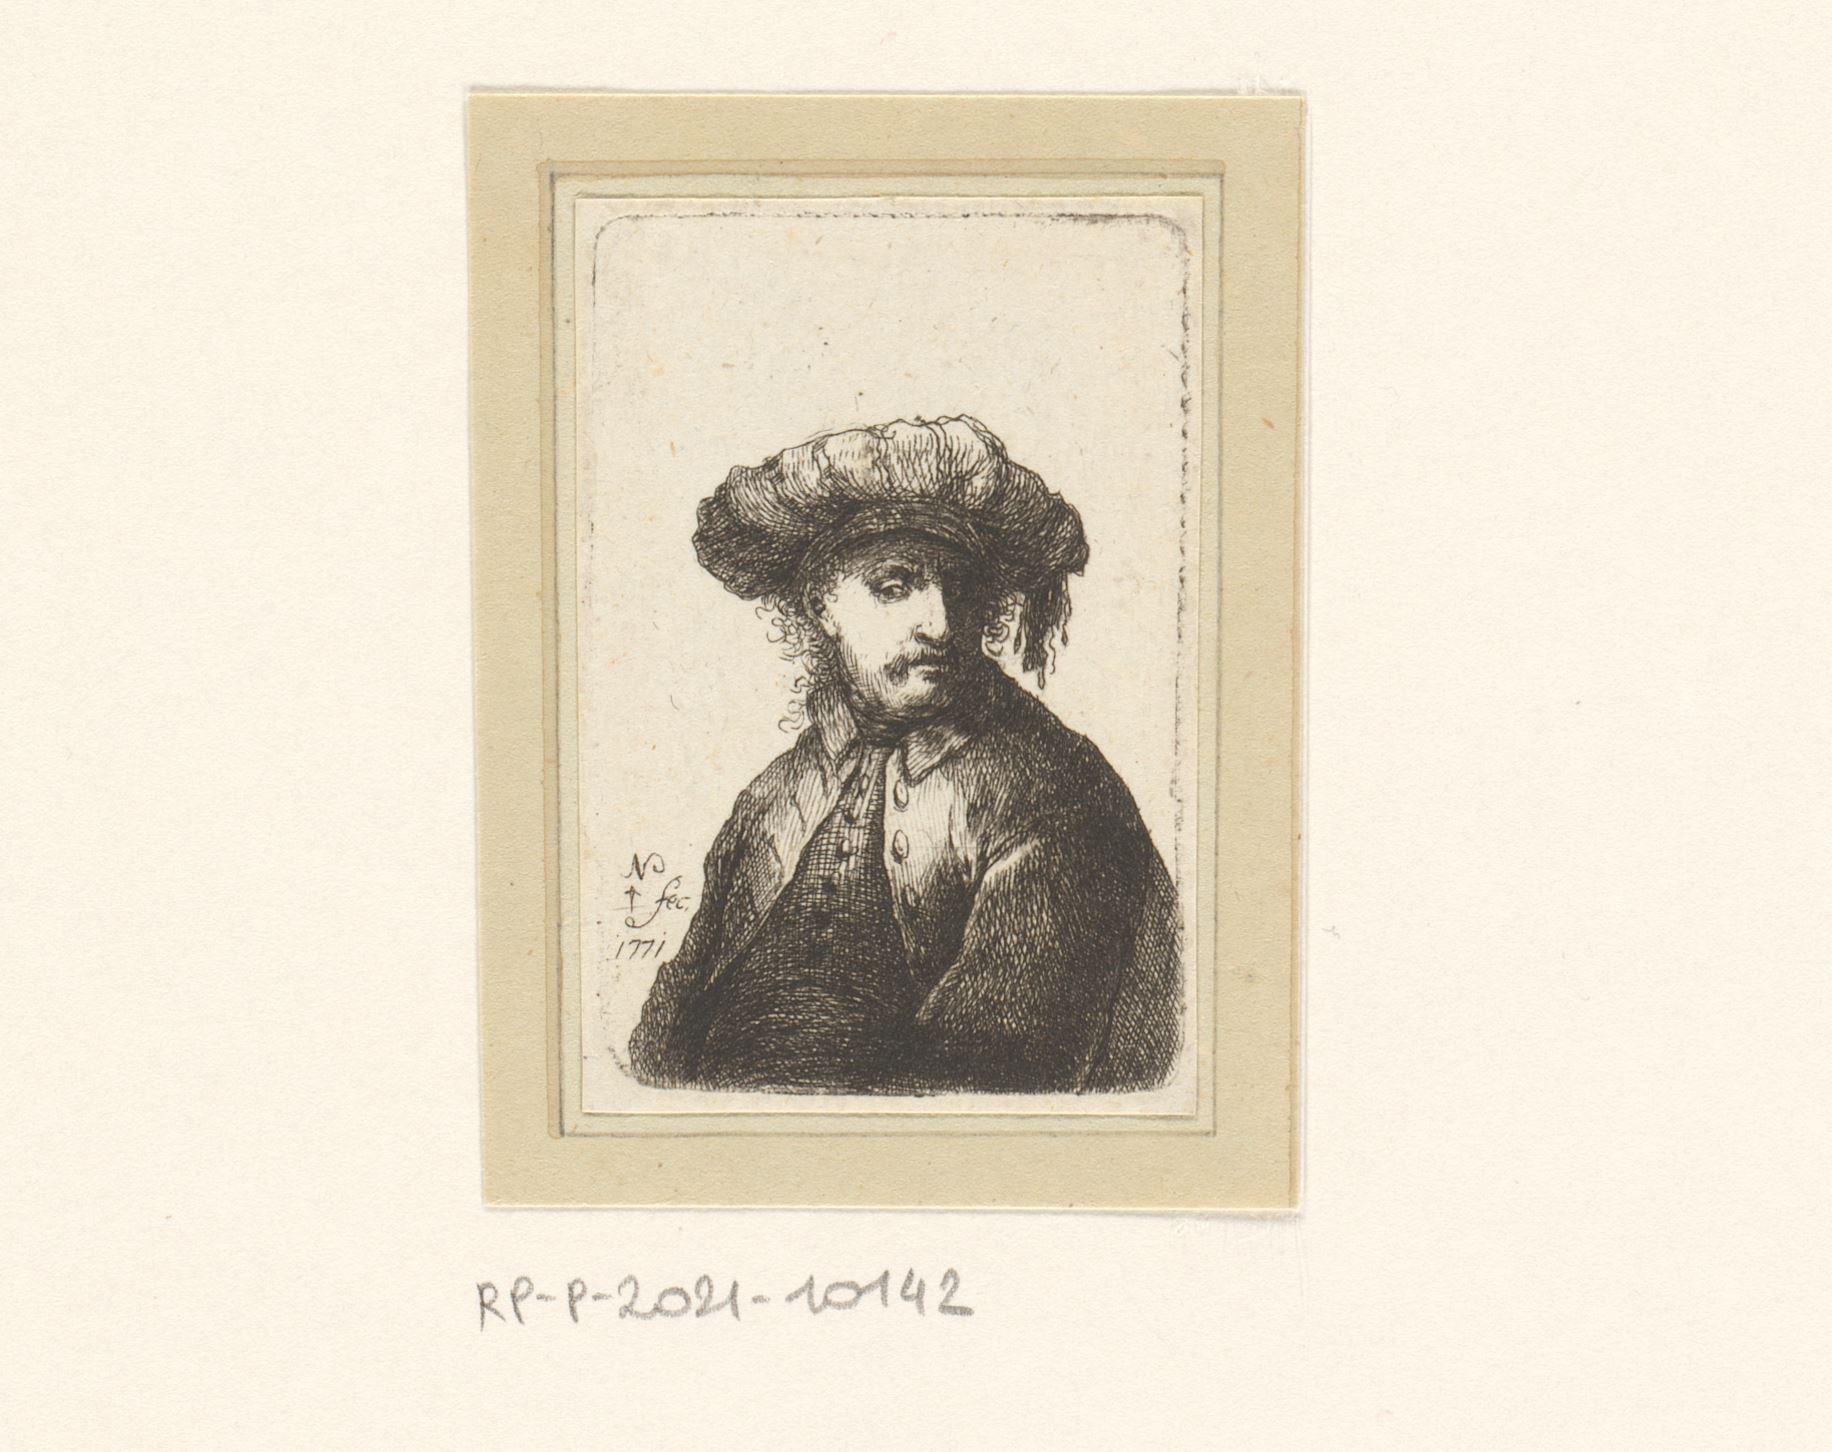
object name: print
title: Man met baret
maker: johann andreas benjamin nothnagel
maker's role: print maker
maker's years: 1729-1804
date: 1771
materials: paper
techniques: etching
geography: germany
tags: adult man, head-gear (barett)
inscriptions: collector's mark: Lugt 2028, inscription: ‘Johann Nothnagel’